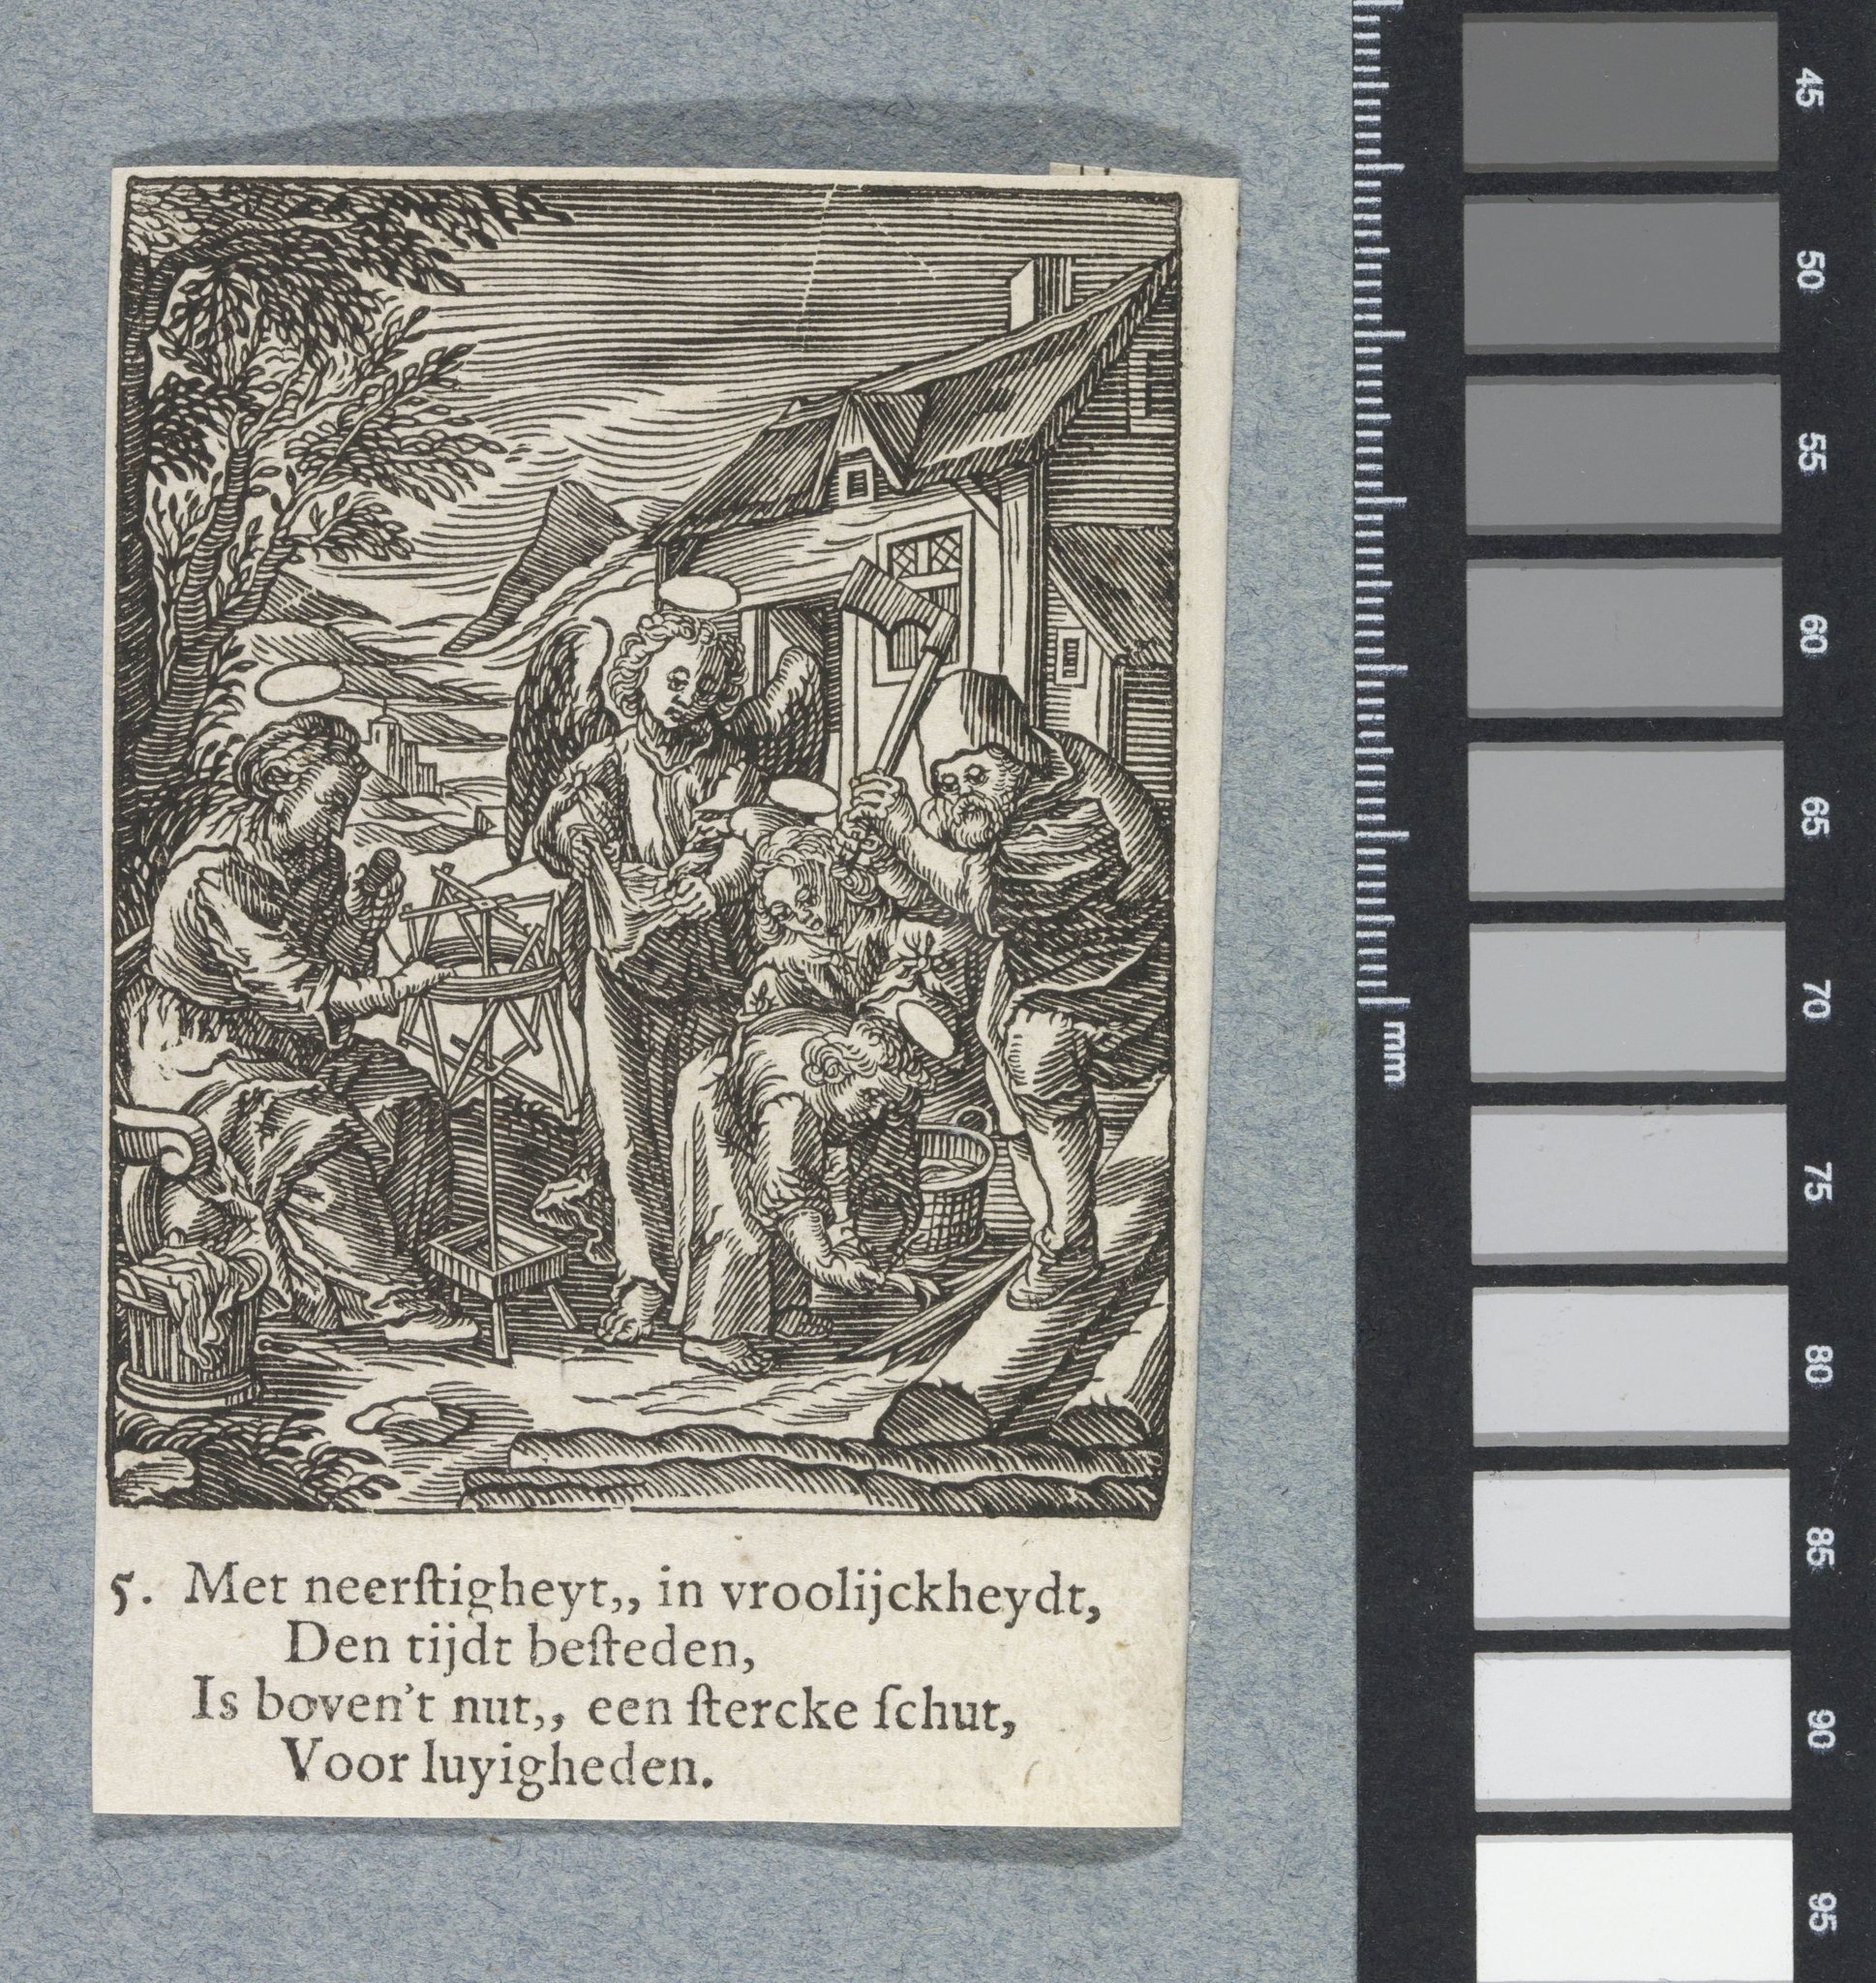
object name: album leaf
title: Christuskind raapt houtsnippers op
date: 1617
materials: paper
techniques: letterpress printing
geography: amsterdam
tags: joseph and the christ-child ~ daily life in nazareth, angels, household occupations of mary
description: De prent verscheen in 1617 bij J.P. Paets als onderdeel van de serie over de jeugd van Christus. Daarnaast werd de houtsnede gebruikt in: Der Zielen Lust-hof. Leuven, I.Jacbosz voor P.J. Paets [= Amsterdam, P.J. Paets], 1629; Bibels Tresoor ofte der zielen lusthof. Amsterdam, P.J. Paets, 1646 en tSchat der Zielen. Amsterdam, P.J. Paets, 1648.